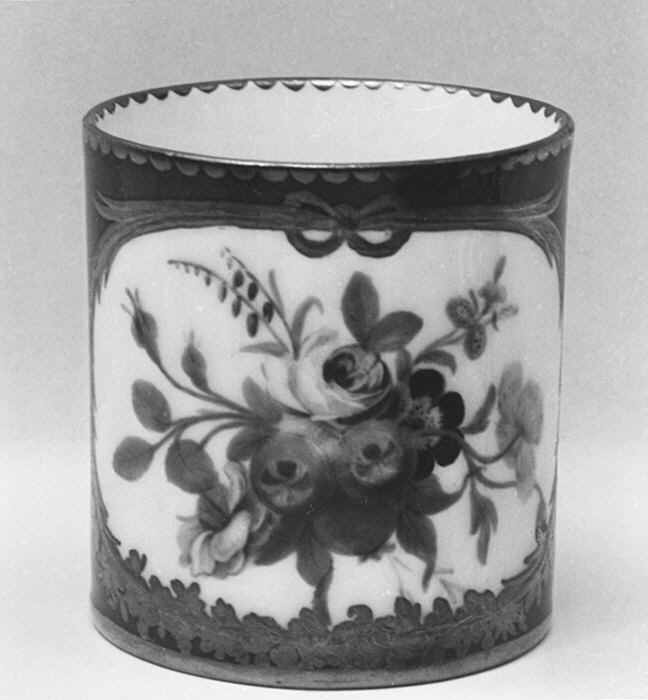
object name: cup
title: Cup (gobelet litron) (one of nine) (part of a service)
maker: sèvres manufactory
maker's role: manufactory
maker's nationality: french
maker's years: 1740-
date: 1786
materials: soft paste porcelain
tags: flowers